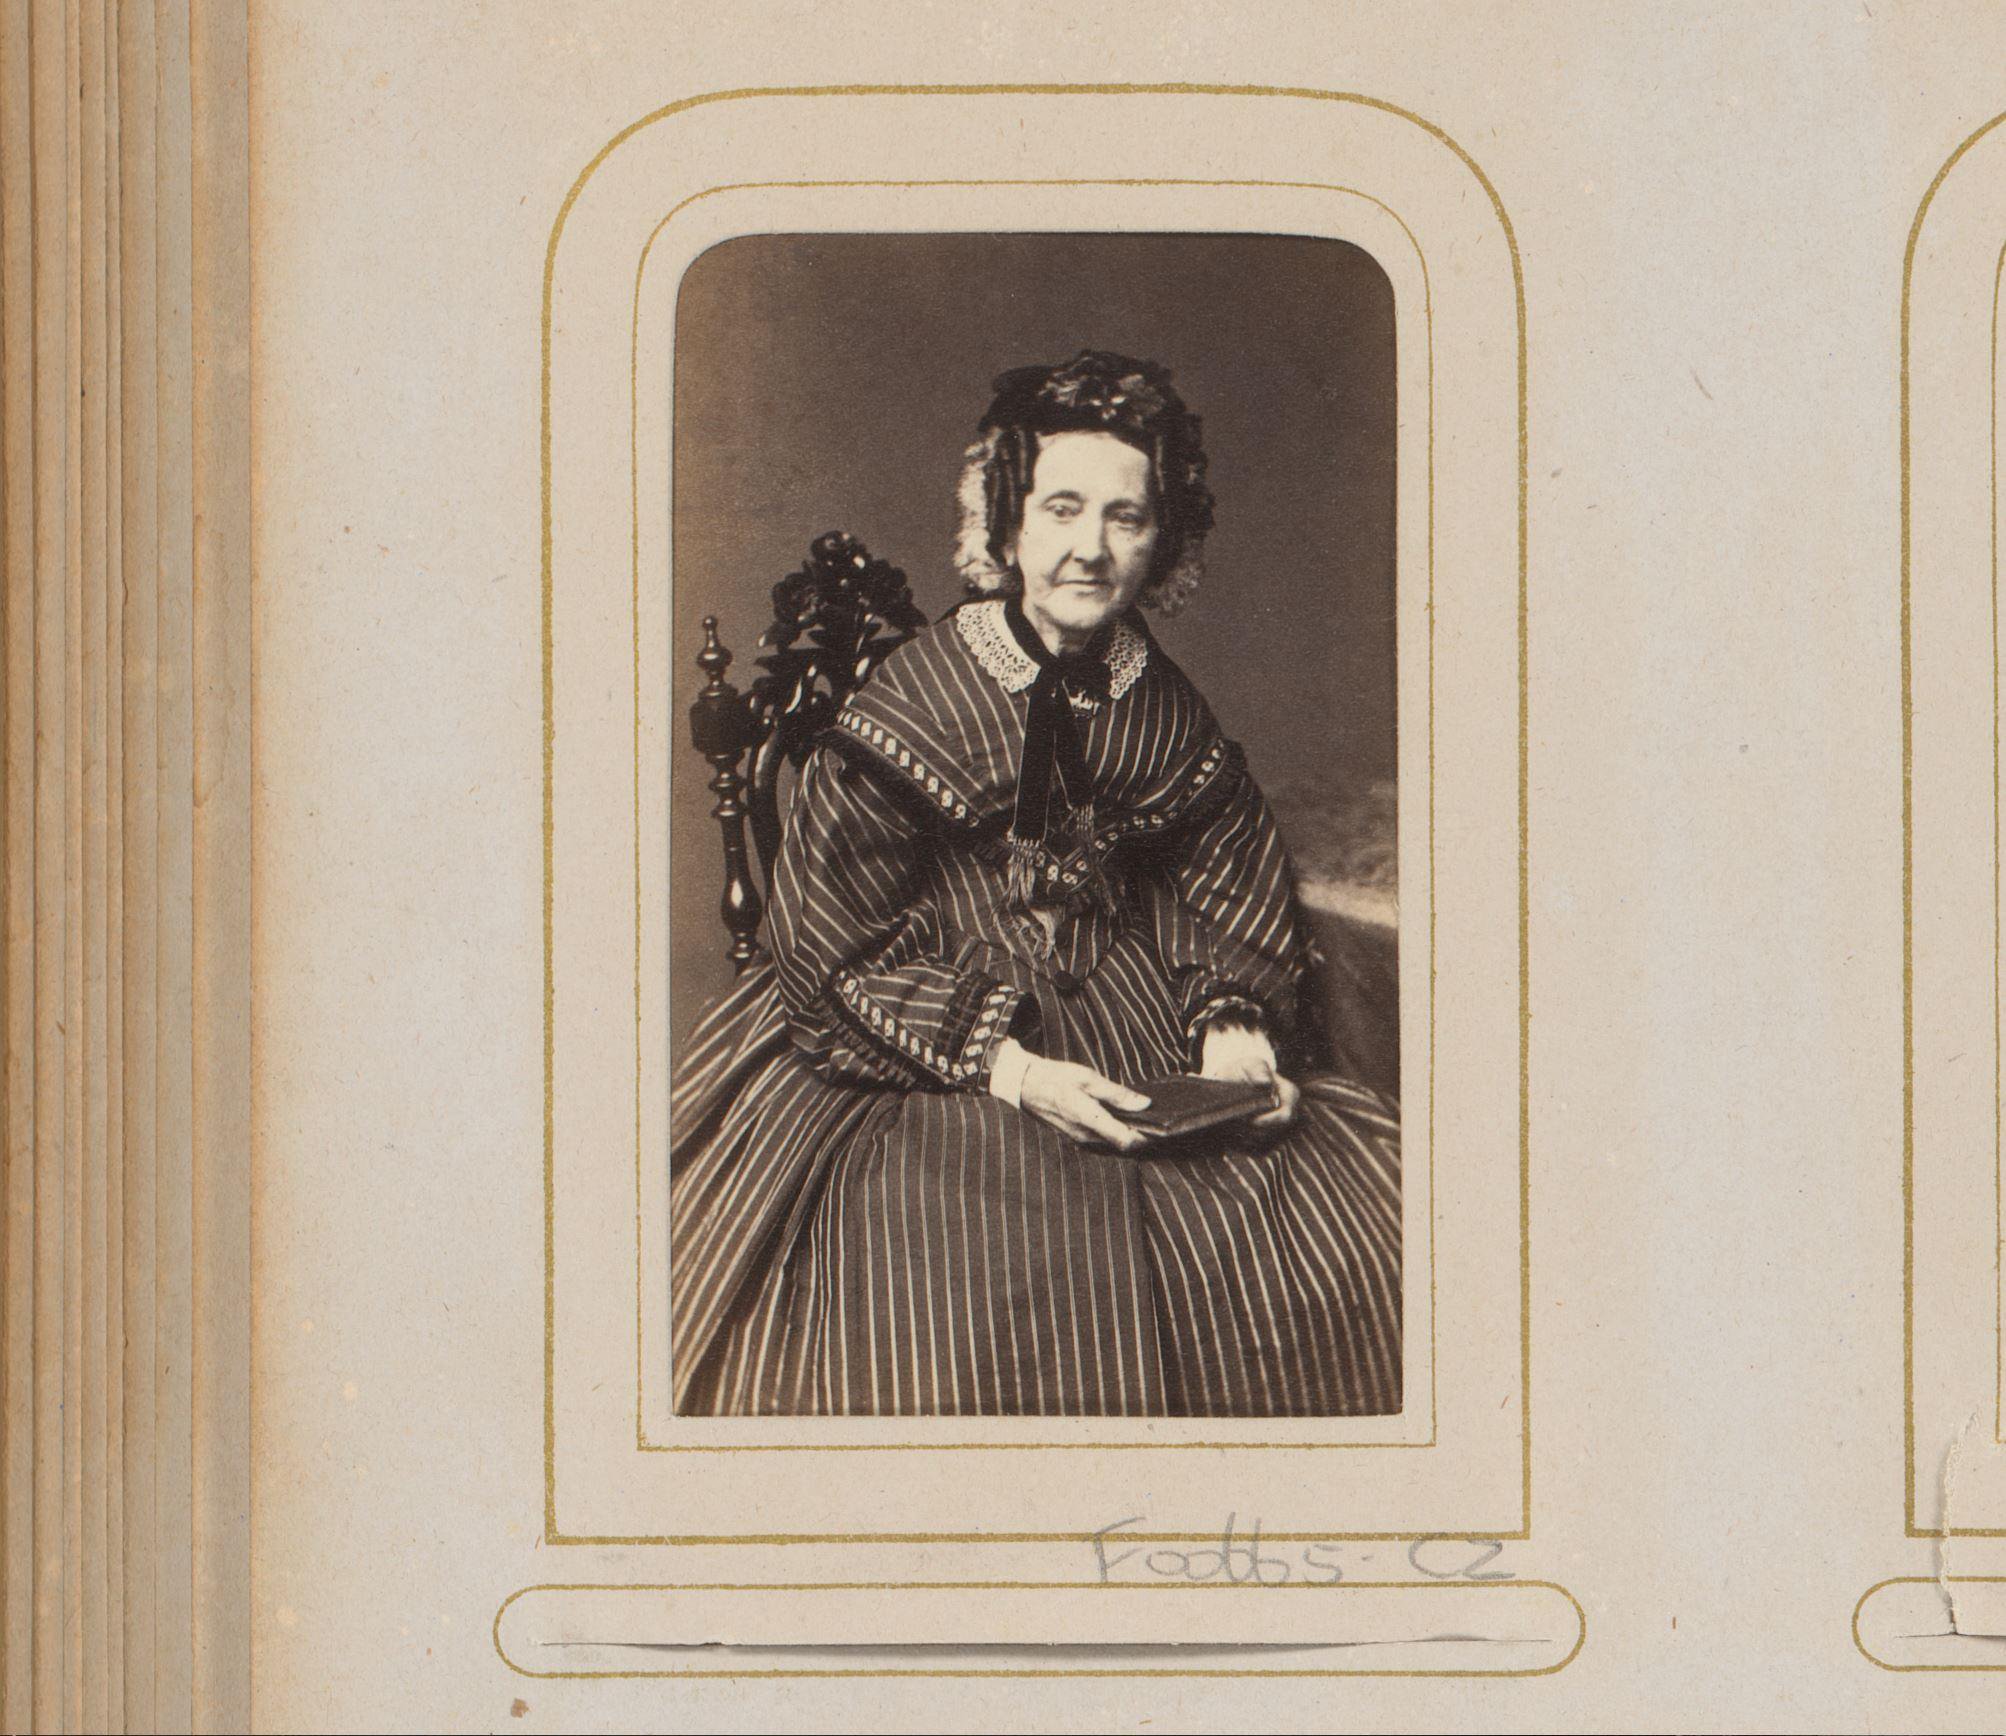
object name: album leaf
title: Portret van een oude vrouw met muts en boek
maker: eduard fuchs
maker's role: painter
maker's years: 1832-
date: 1859-1870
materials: cardboard, photographic support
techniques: albumen print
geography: leeuwarden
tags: historical persons, head-gear: cap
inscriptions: inscription: ‘Photographie/ E. Fuchs/ Leeuwarden’